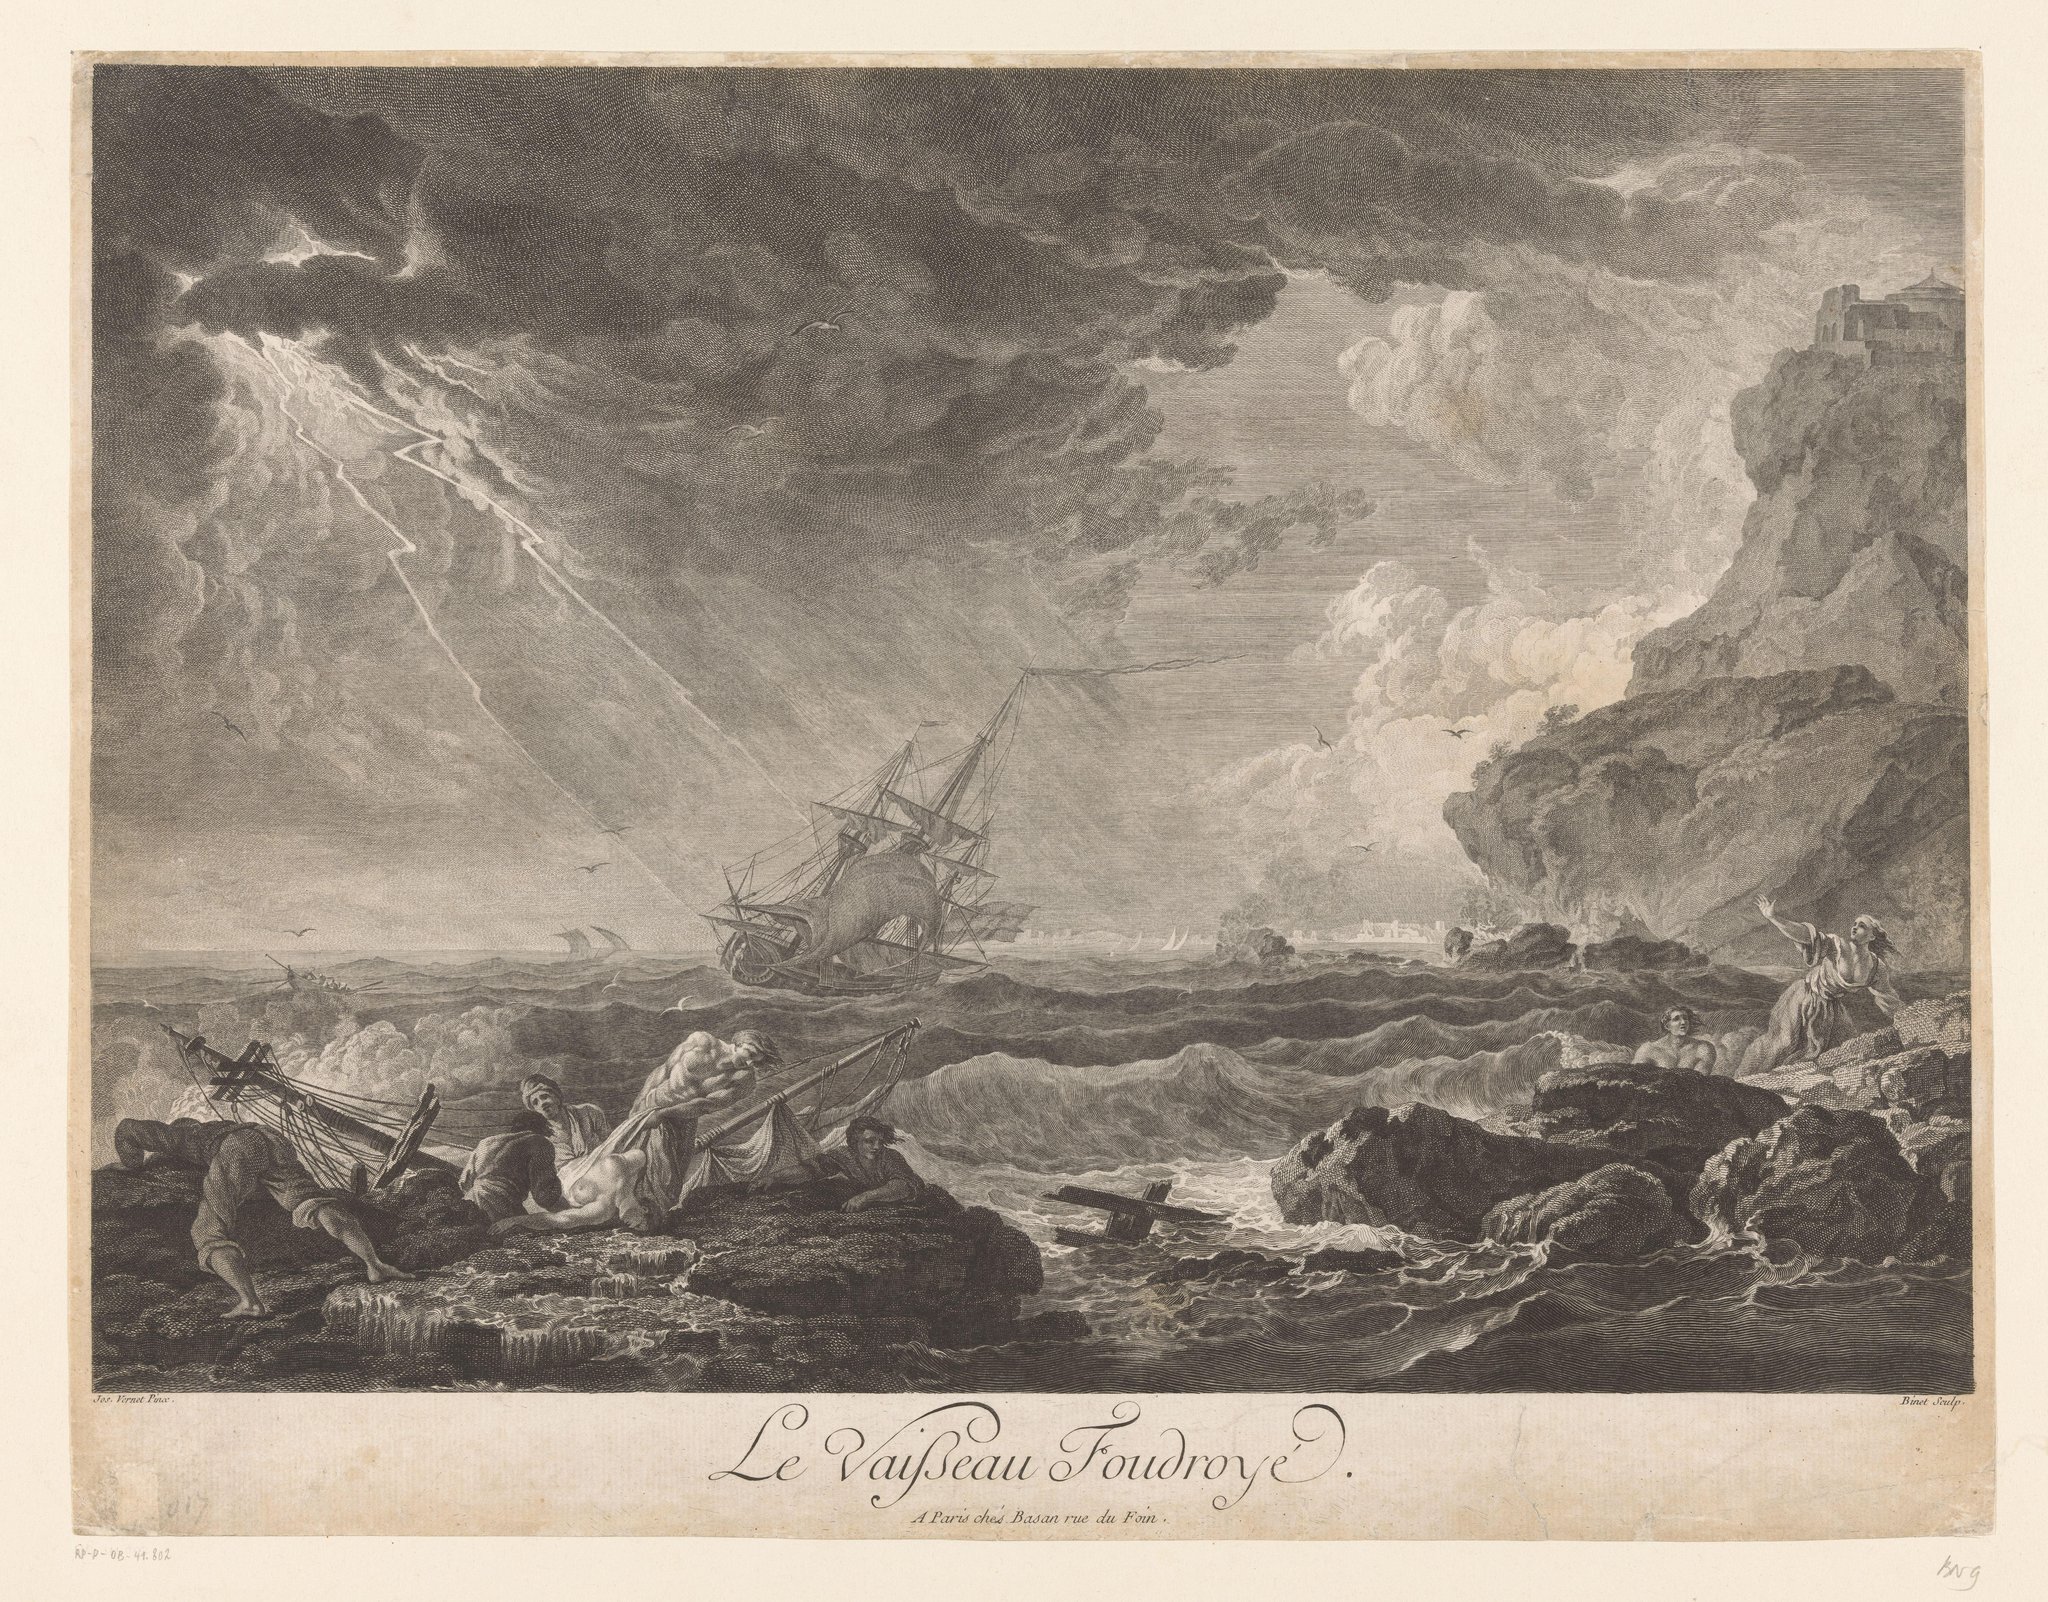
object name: print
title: Zeezicht met storm en gekapseisde boot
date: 1754-1800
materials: paper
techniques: engraving, etching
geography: france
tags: sea (seascape), lightning, flash of lightning, thunderbolt, storm at sea, drowning (violent death ~ water)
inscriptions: watermark